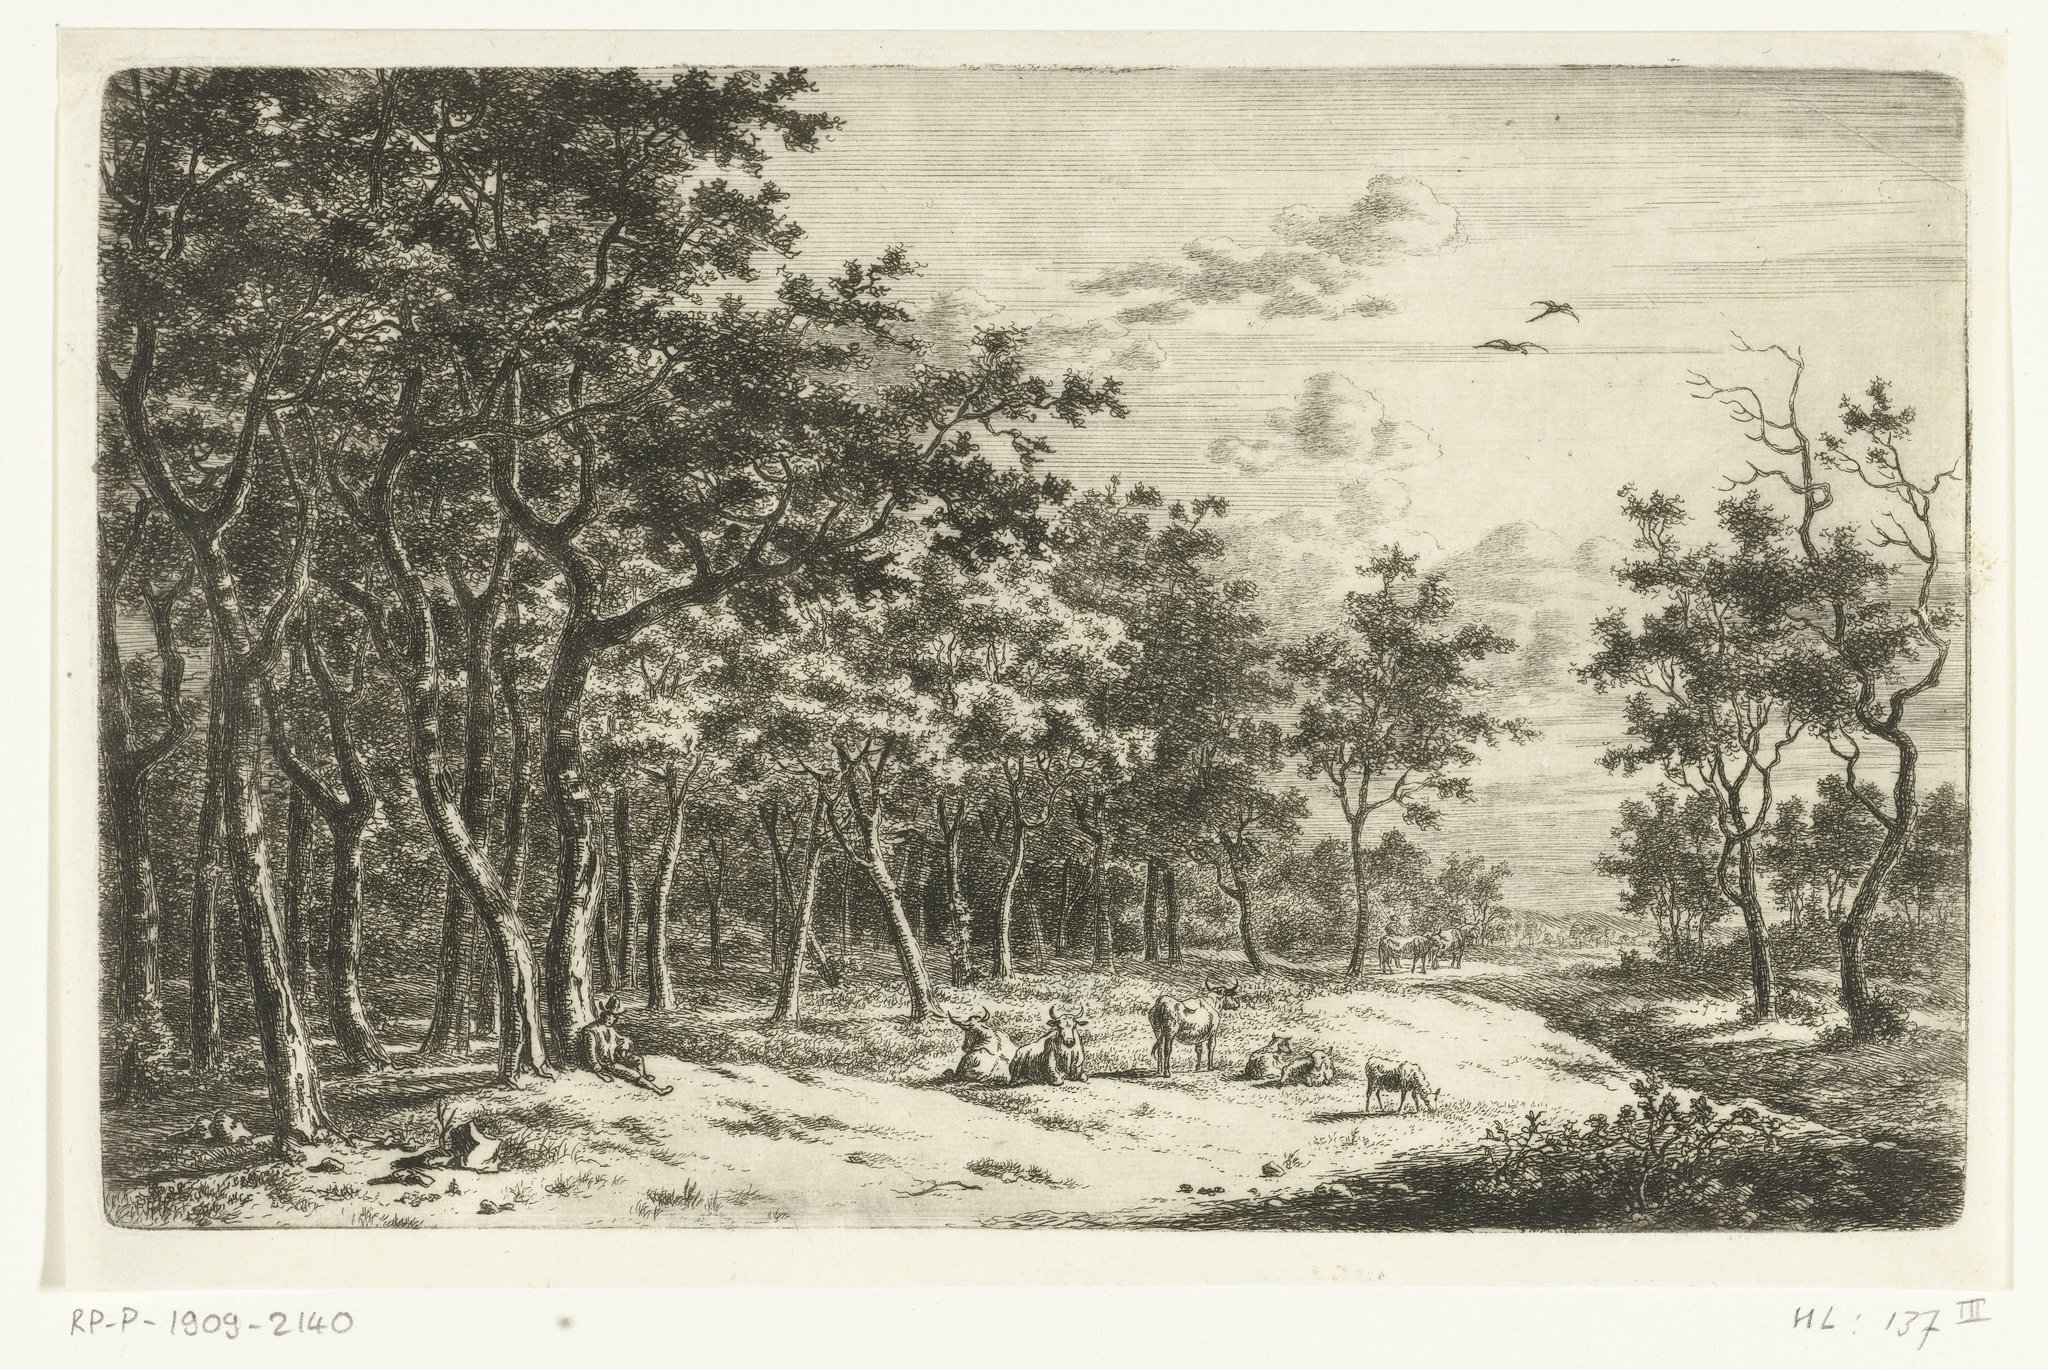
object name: print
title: Landschap met herder en zijn kudde aan de rand van het bos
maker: ernst willem jan bagelaar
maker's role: draughtsman, print maker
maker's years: 1775-1837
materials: paper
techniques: drypoint, etching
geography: netherlands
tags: herding, herdsman, herdswoman, shepherd, shepherdess, cowherd, etc.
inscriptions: collector's mark: Lugt 2228